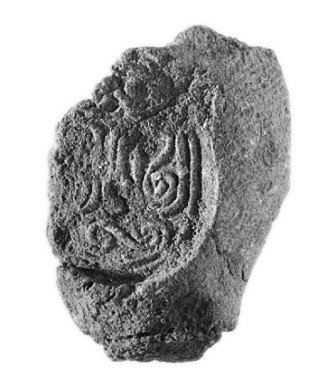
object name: sealing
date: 1981-1640 BCE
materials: mud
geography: egypt